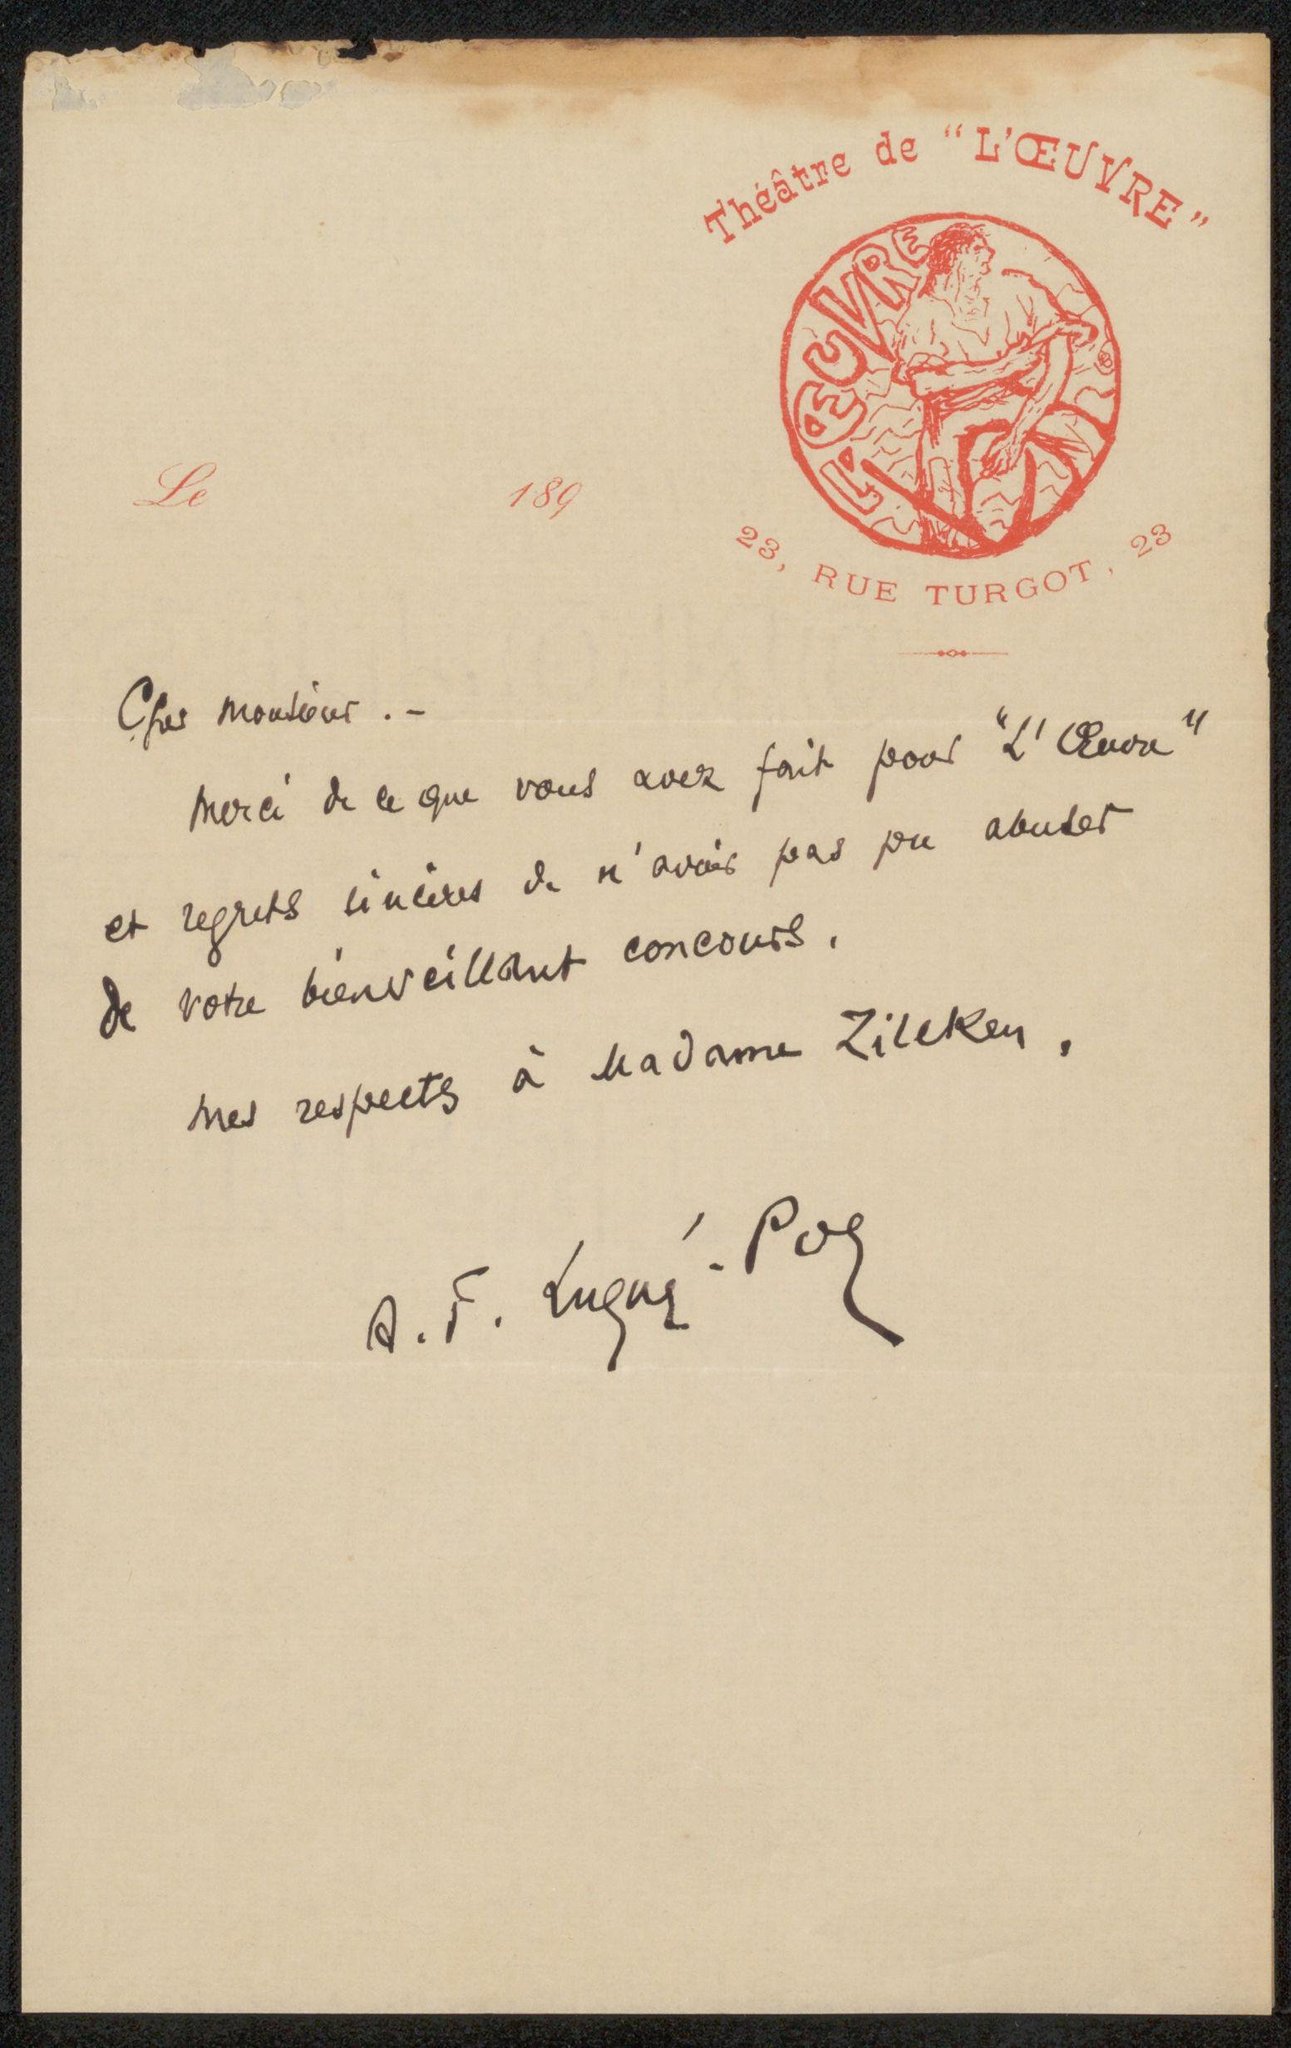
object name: letter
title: Brief aan Philip Zilcken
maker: lugné-poe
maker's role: acteur, theaterdirecteur, theatervormgever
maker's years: 1869-1940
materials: ink, paper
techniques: pen, printing, writing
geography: paris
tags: painter, draughtsman, philip zilcken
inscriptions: collector's mark: ‘RPK’, watermark